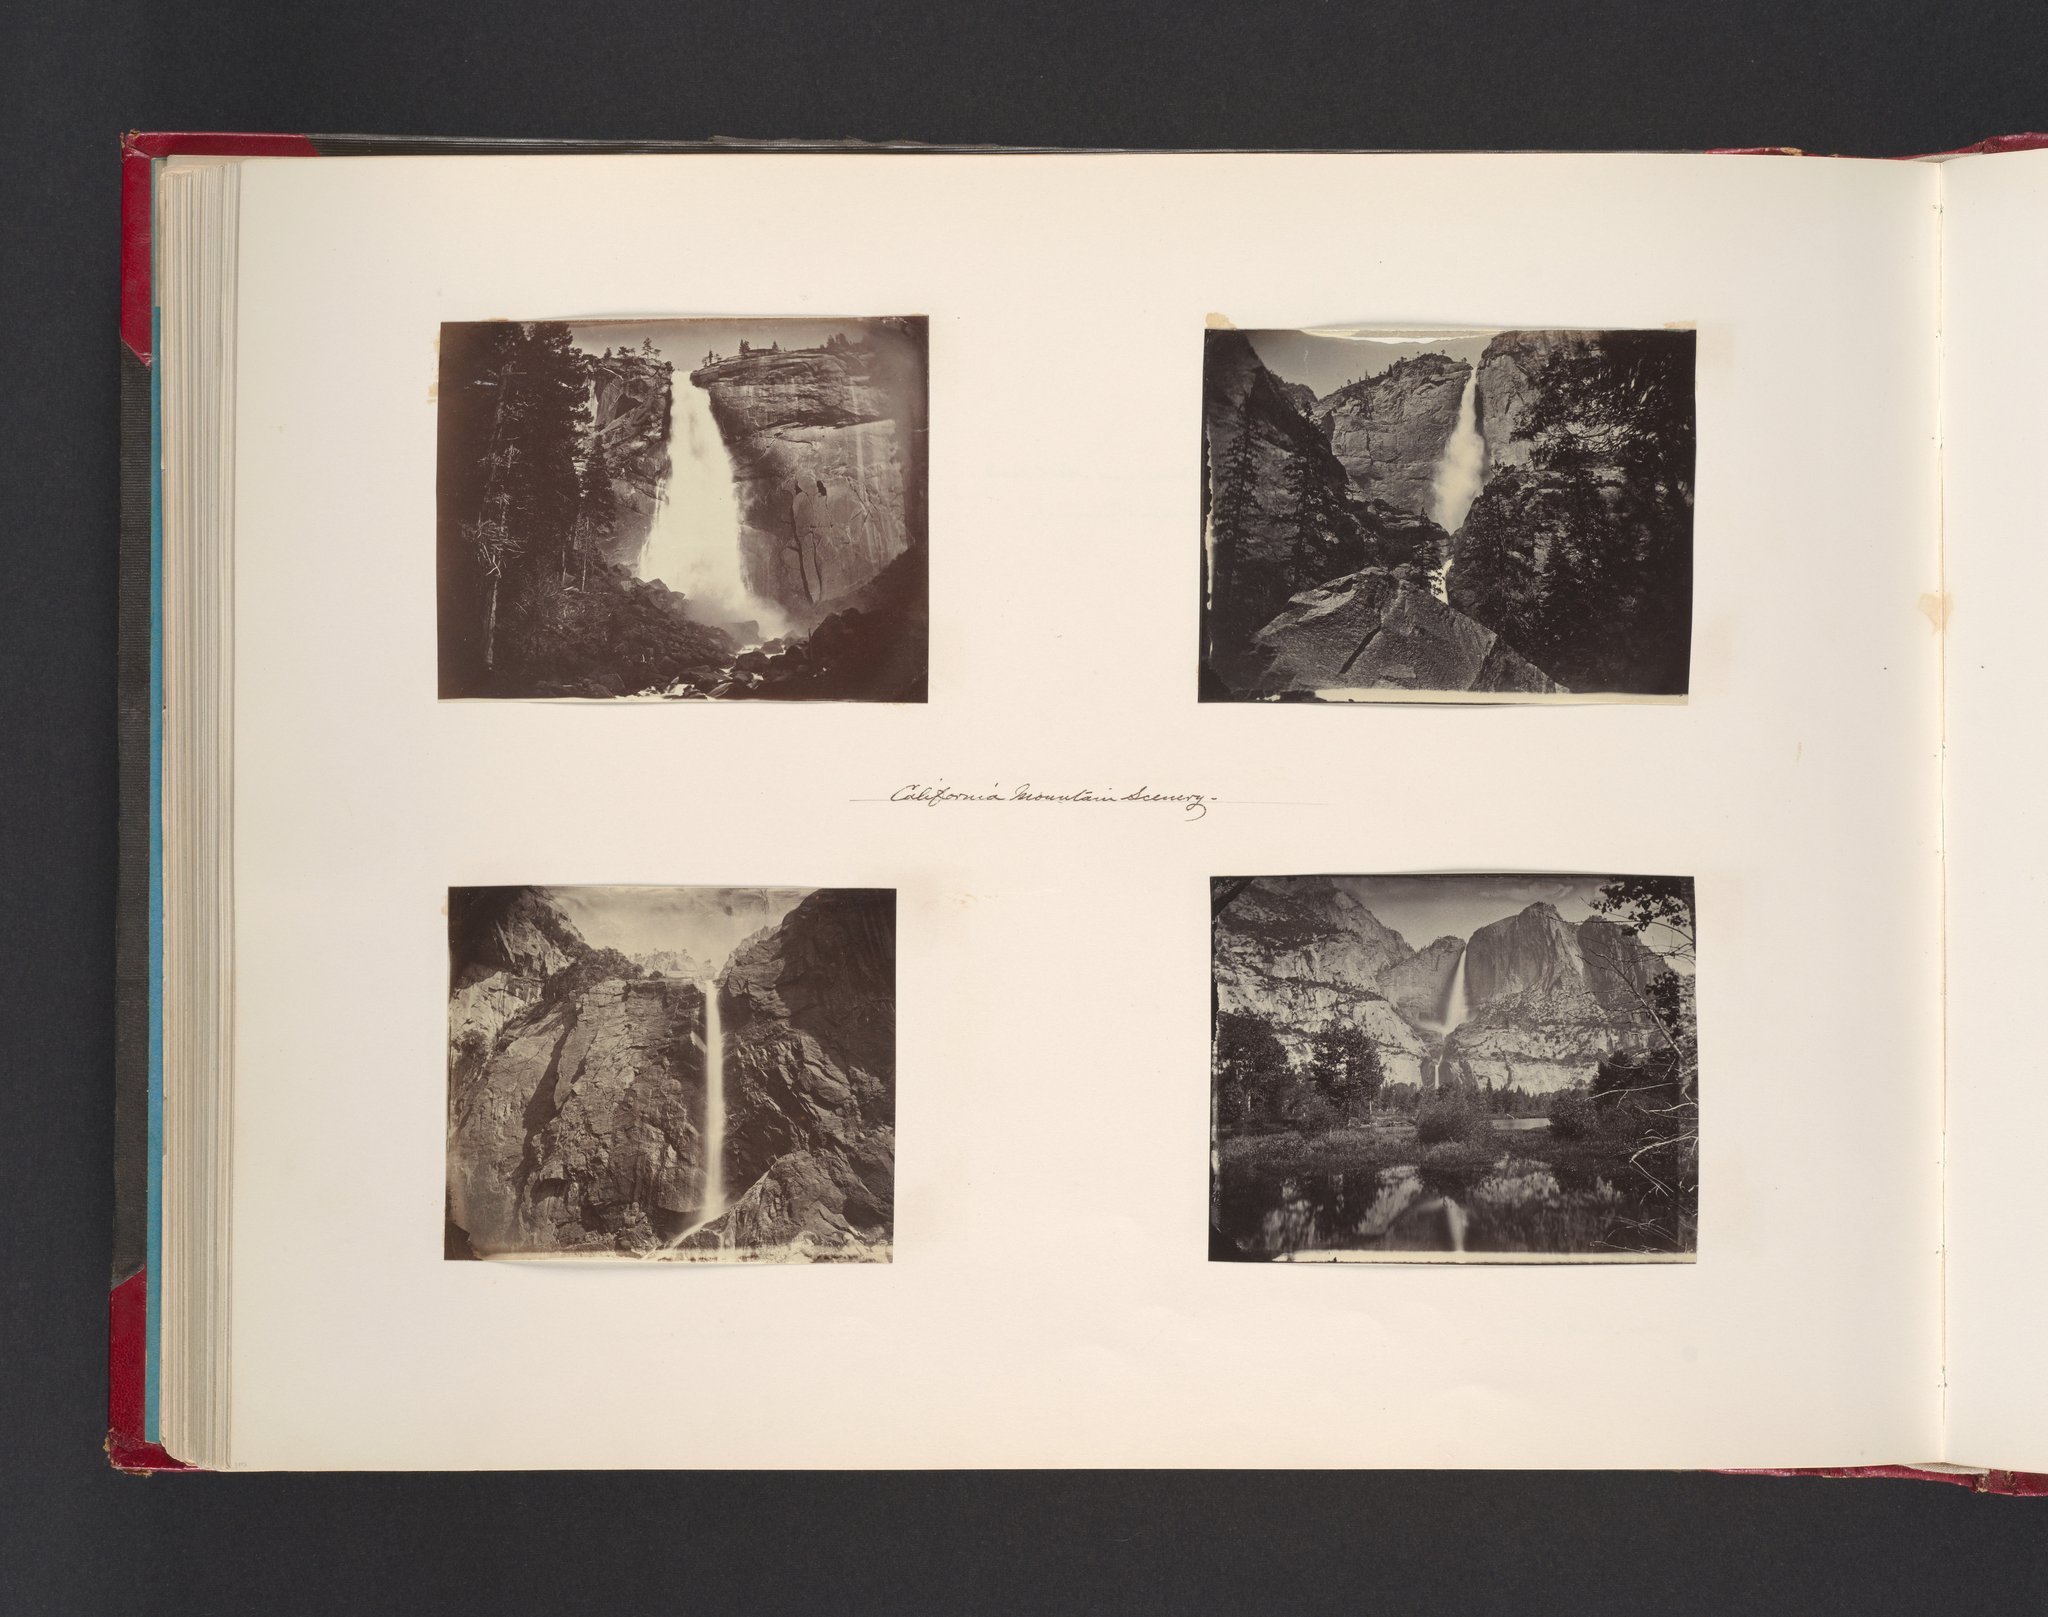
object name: photograph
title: California Mountain Scenery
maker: john thomson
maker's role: artist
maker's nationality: british, scottish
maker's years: 1837-1921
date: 1865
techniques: albumen silver print, glass negative